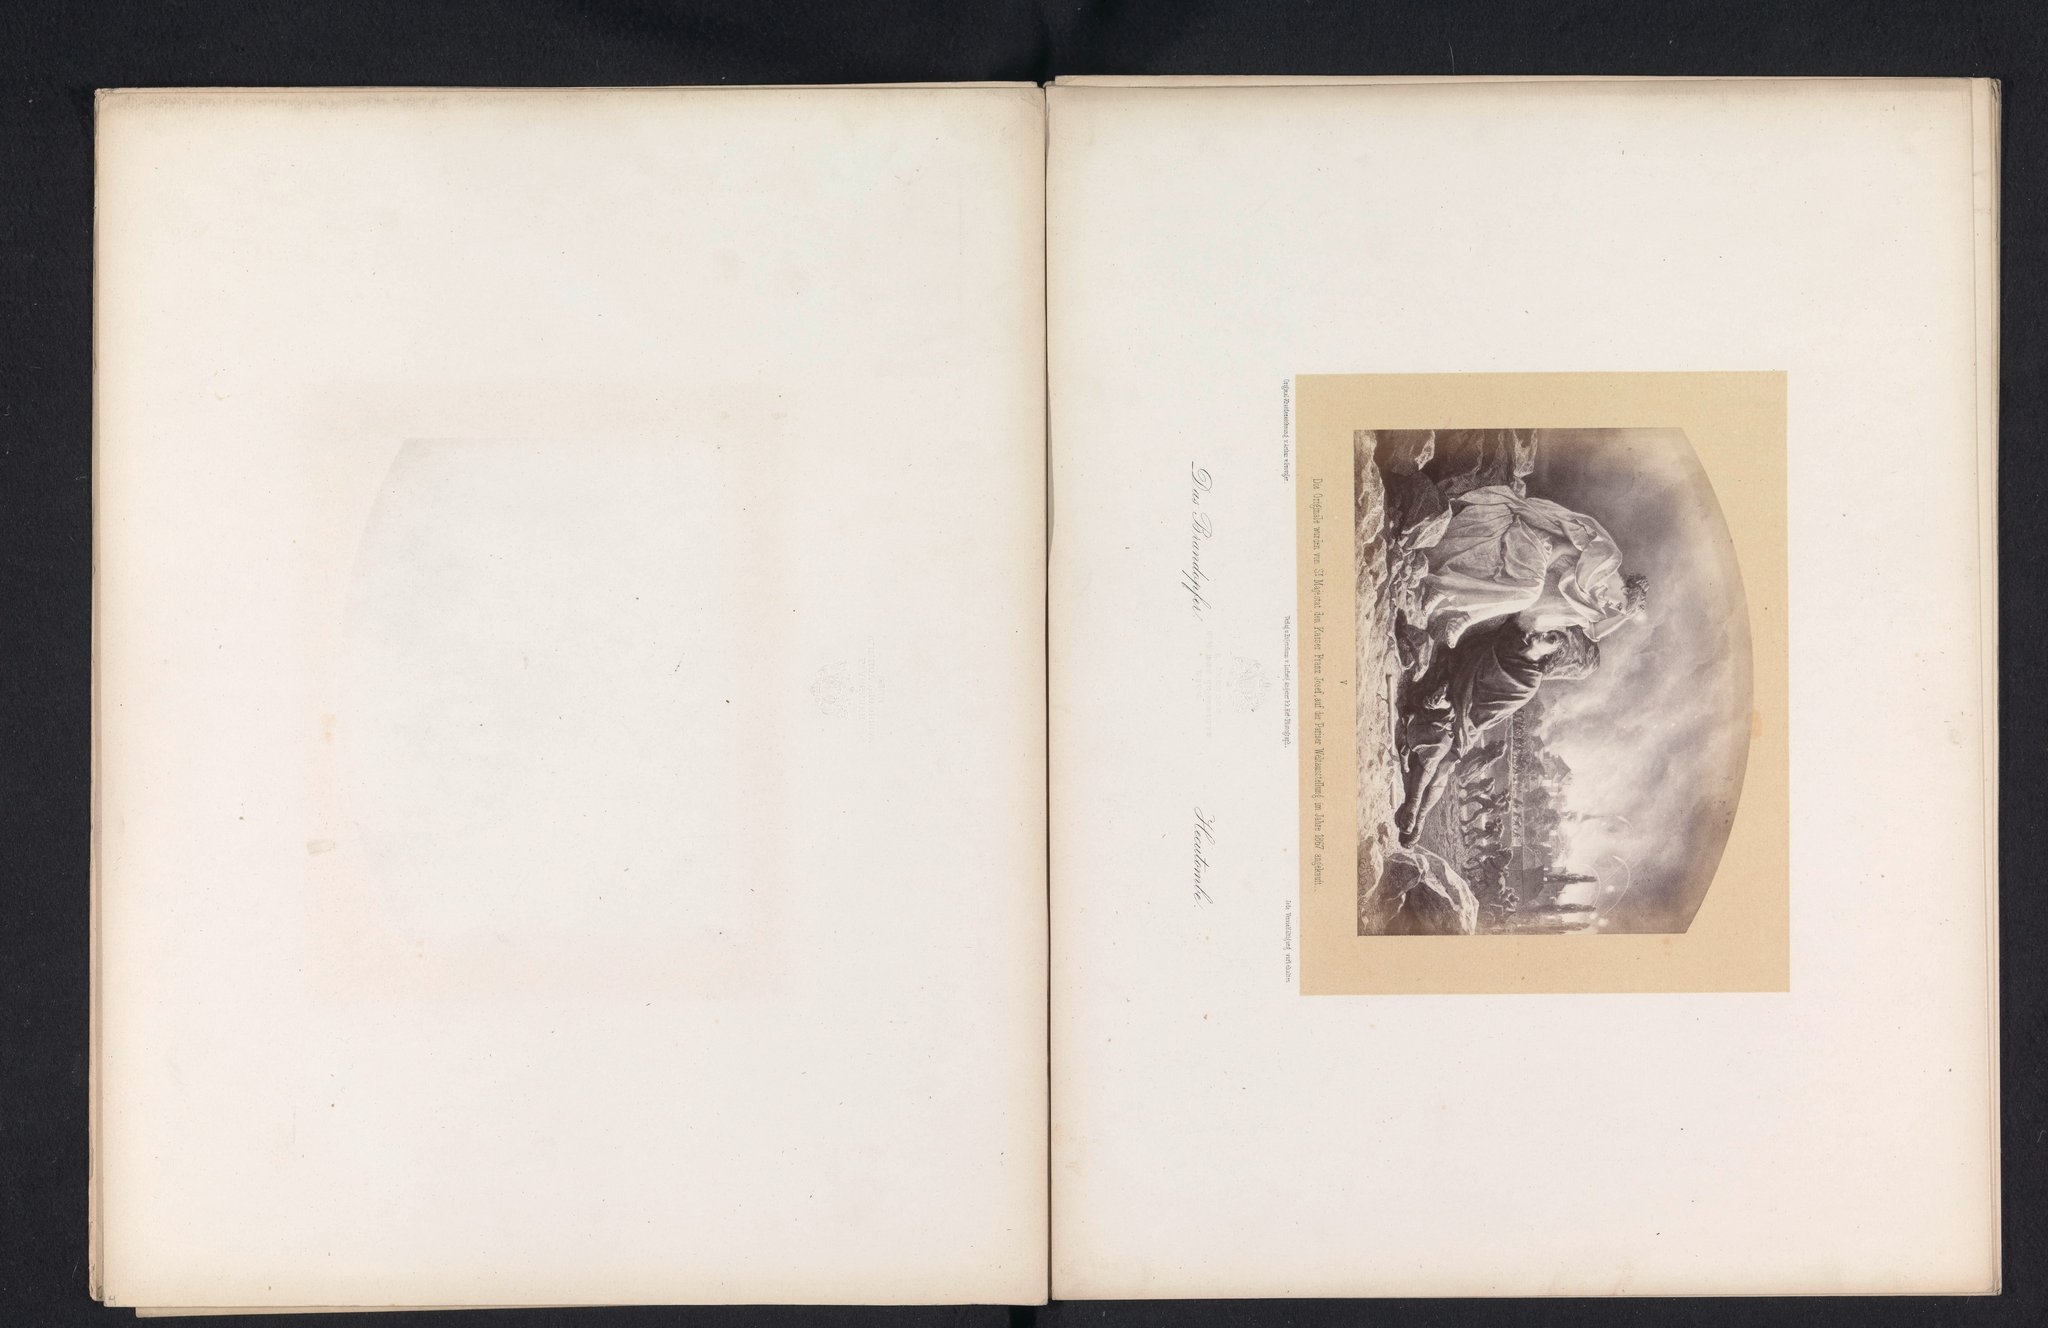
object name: photograph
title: Das Brandopfer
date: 1867-1868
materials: photographic support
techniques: albumen print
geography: vienna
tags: rescue from fire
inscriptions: inscription: ‘Die Originale wurden von Sr Majestat den Kaiser Franz Josef auf der Pariser Weltausstellung im Jahre 1867 angekauft.’, number: ‘V.’